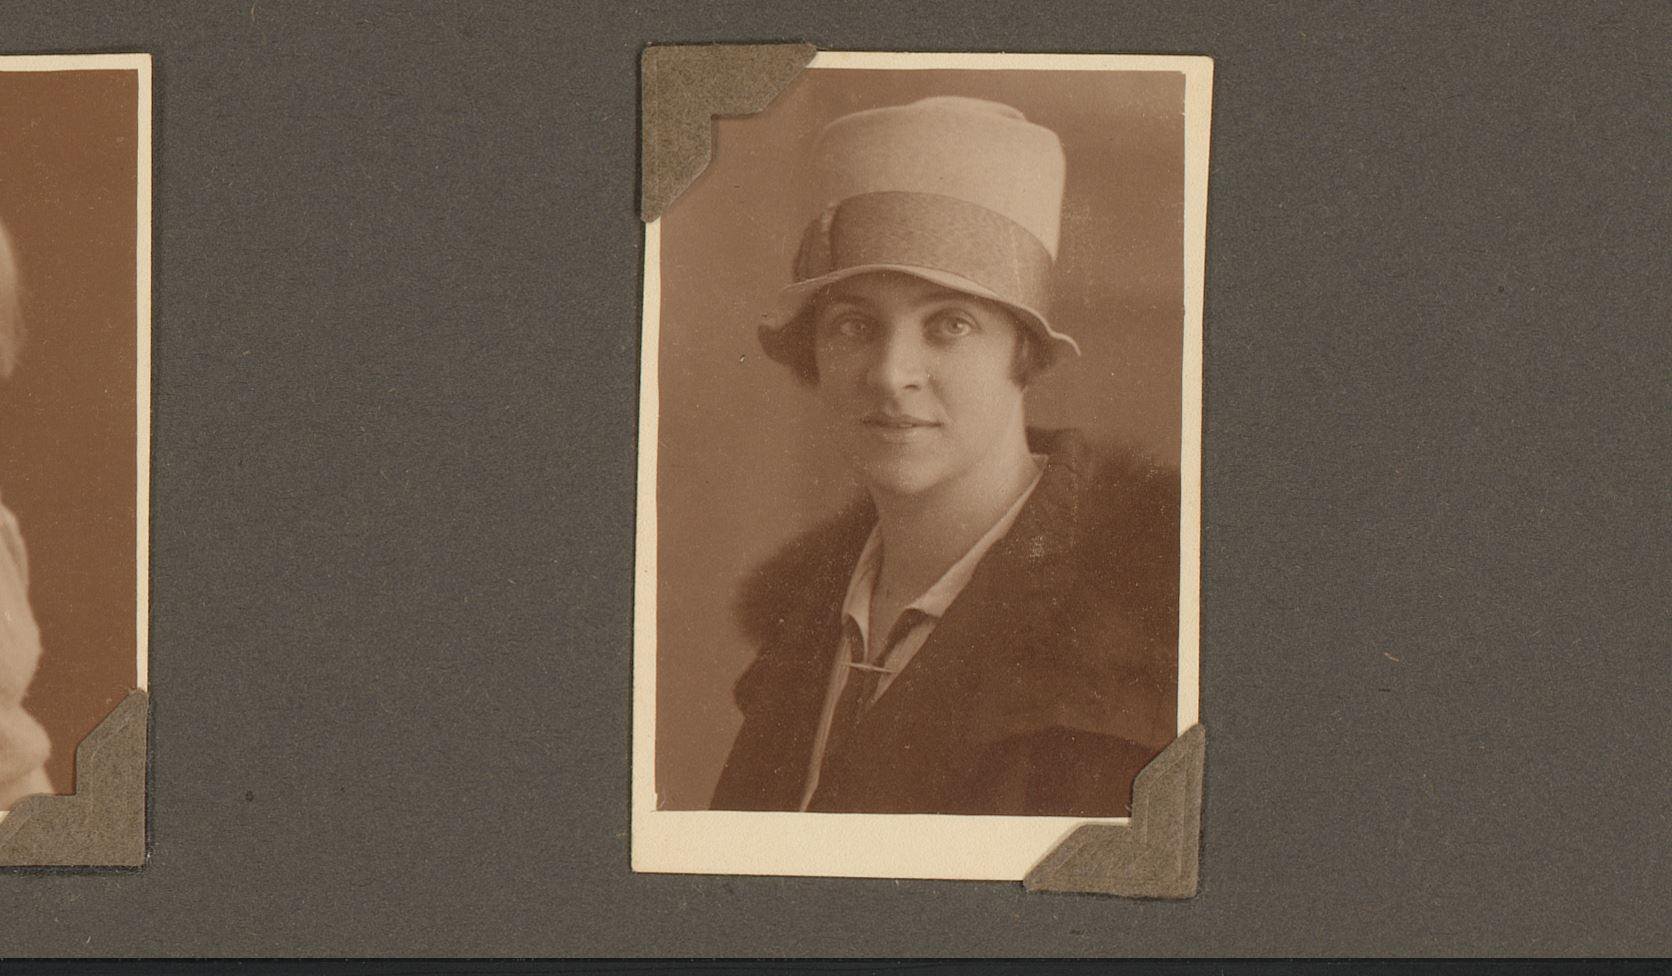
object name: album leaf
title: Portret van een jonge vrouw met hoed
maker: Anonymous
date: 1920-1930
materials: photographic support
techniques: gelatin silver print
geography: netherlands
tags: historical persons - bb - woman